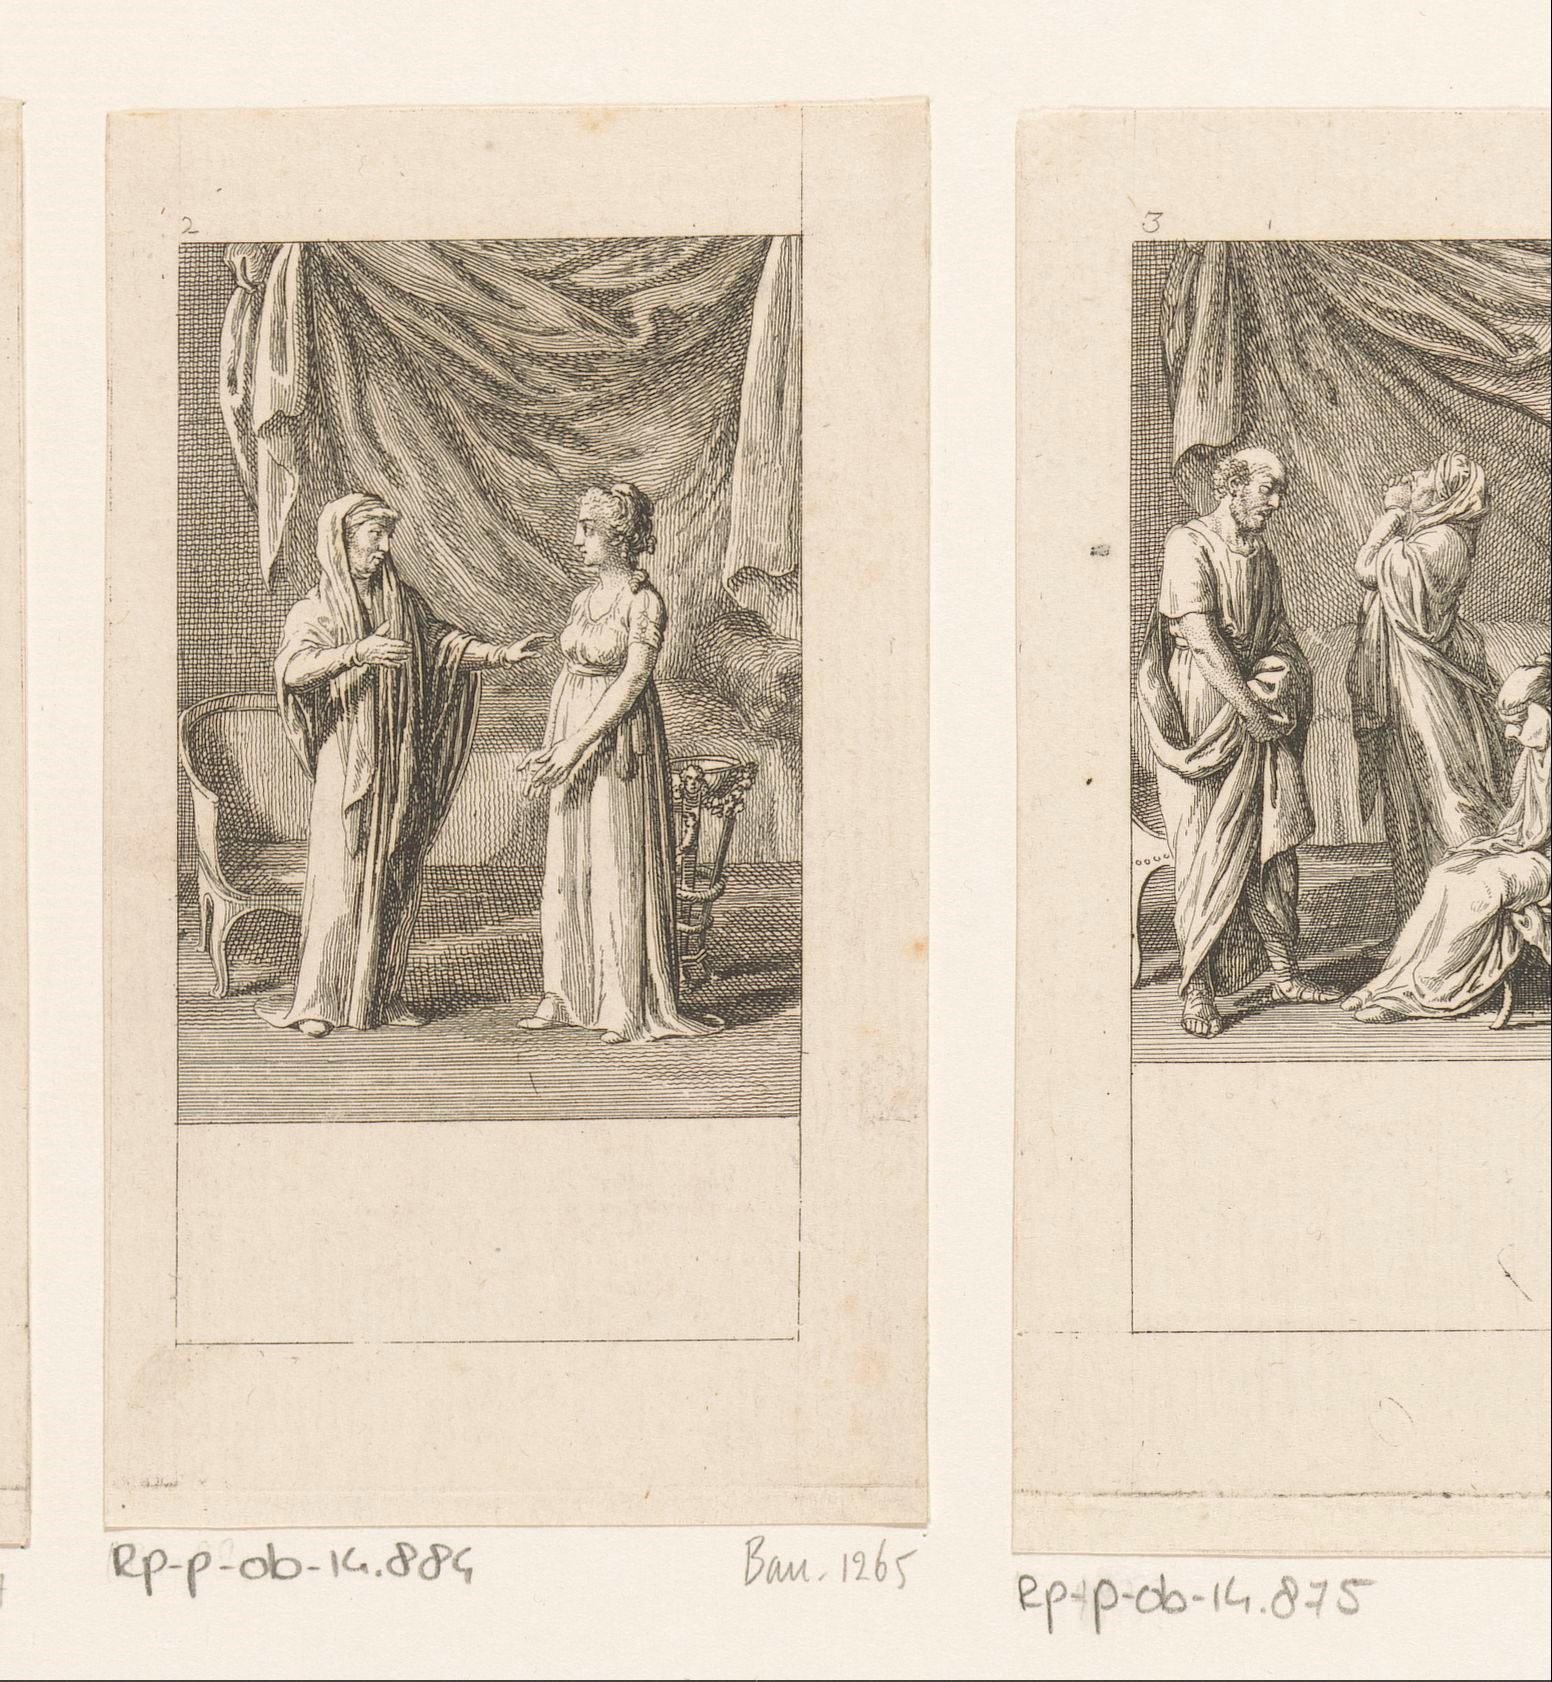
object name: print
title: Volumnia en Virgilia in gesprek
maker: daniel nikolaus chodowiecki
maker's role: draughtsman, print maker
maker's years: 1726-1801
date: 1786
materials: paper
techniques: etching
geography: berlin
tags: william shakespeare, (story of) coriolanus, literature, conversation, dialogue; conversation piece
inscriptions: collector's mark: Lugt 2228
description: Vervaardigd voor William Shakespeares 'Coriolan'. Latere staat gebruikt voor: Königl. Grosbrit. Genealogischer Kalender auf das Jahr 1787. Lauenburg: J. G. Berenberg, [1786].